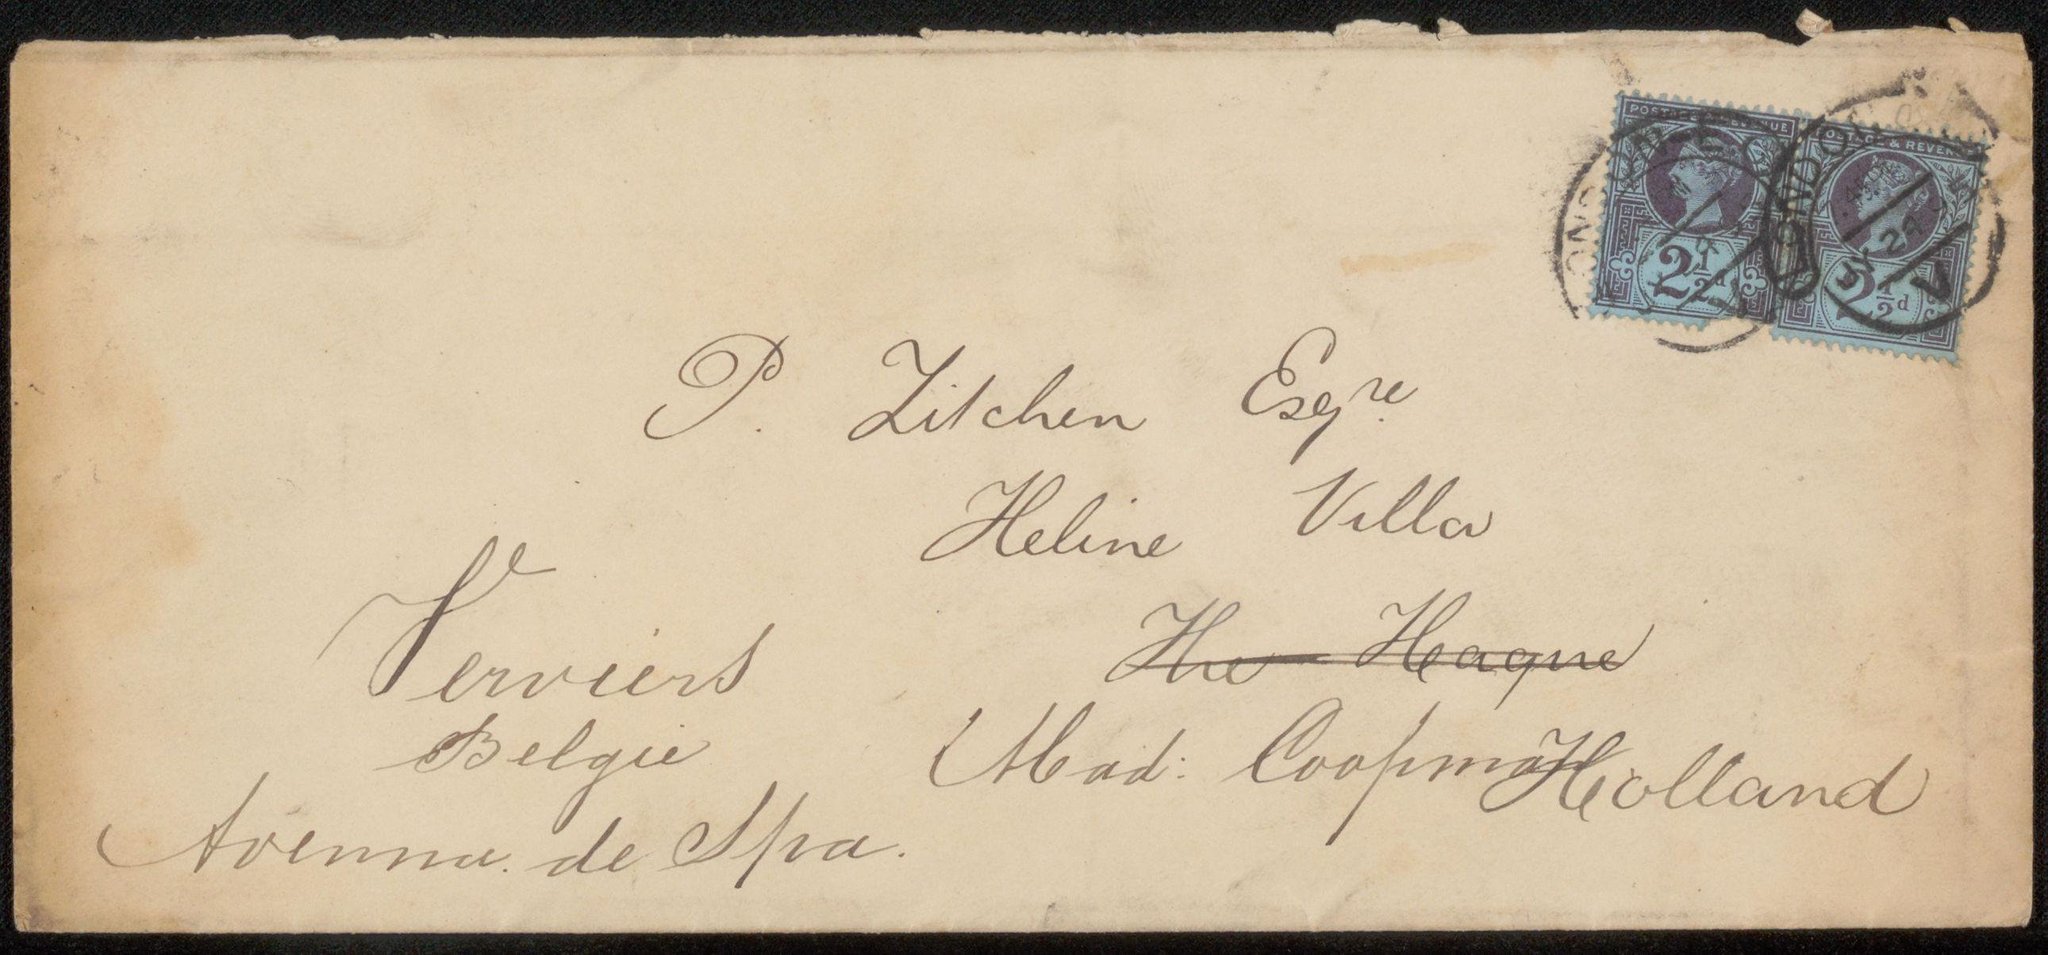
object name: envelope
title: Envelop aan Philip Zilcken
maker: elbert jan van wisselingh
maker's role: kunsthandelaar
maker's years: 1848-1912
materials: ink, paper, pencil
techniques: pen, writing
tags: the hague, painter, draughtsman, philip zilcken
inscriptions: collector's mark: ‘RPK’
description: Envelop bevat aantekening van Philip Zilcken.